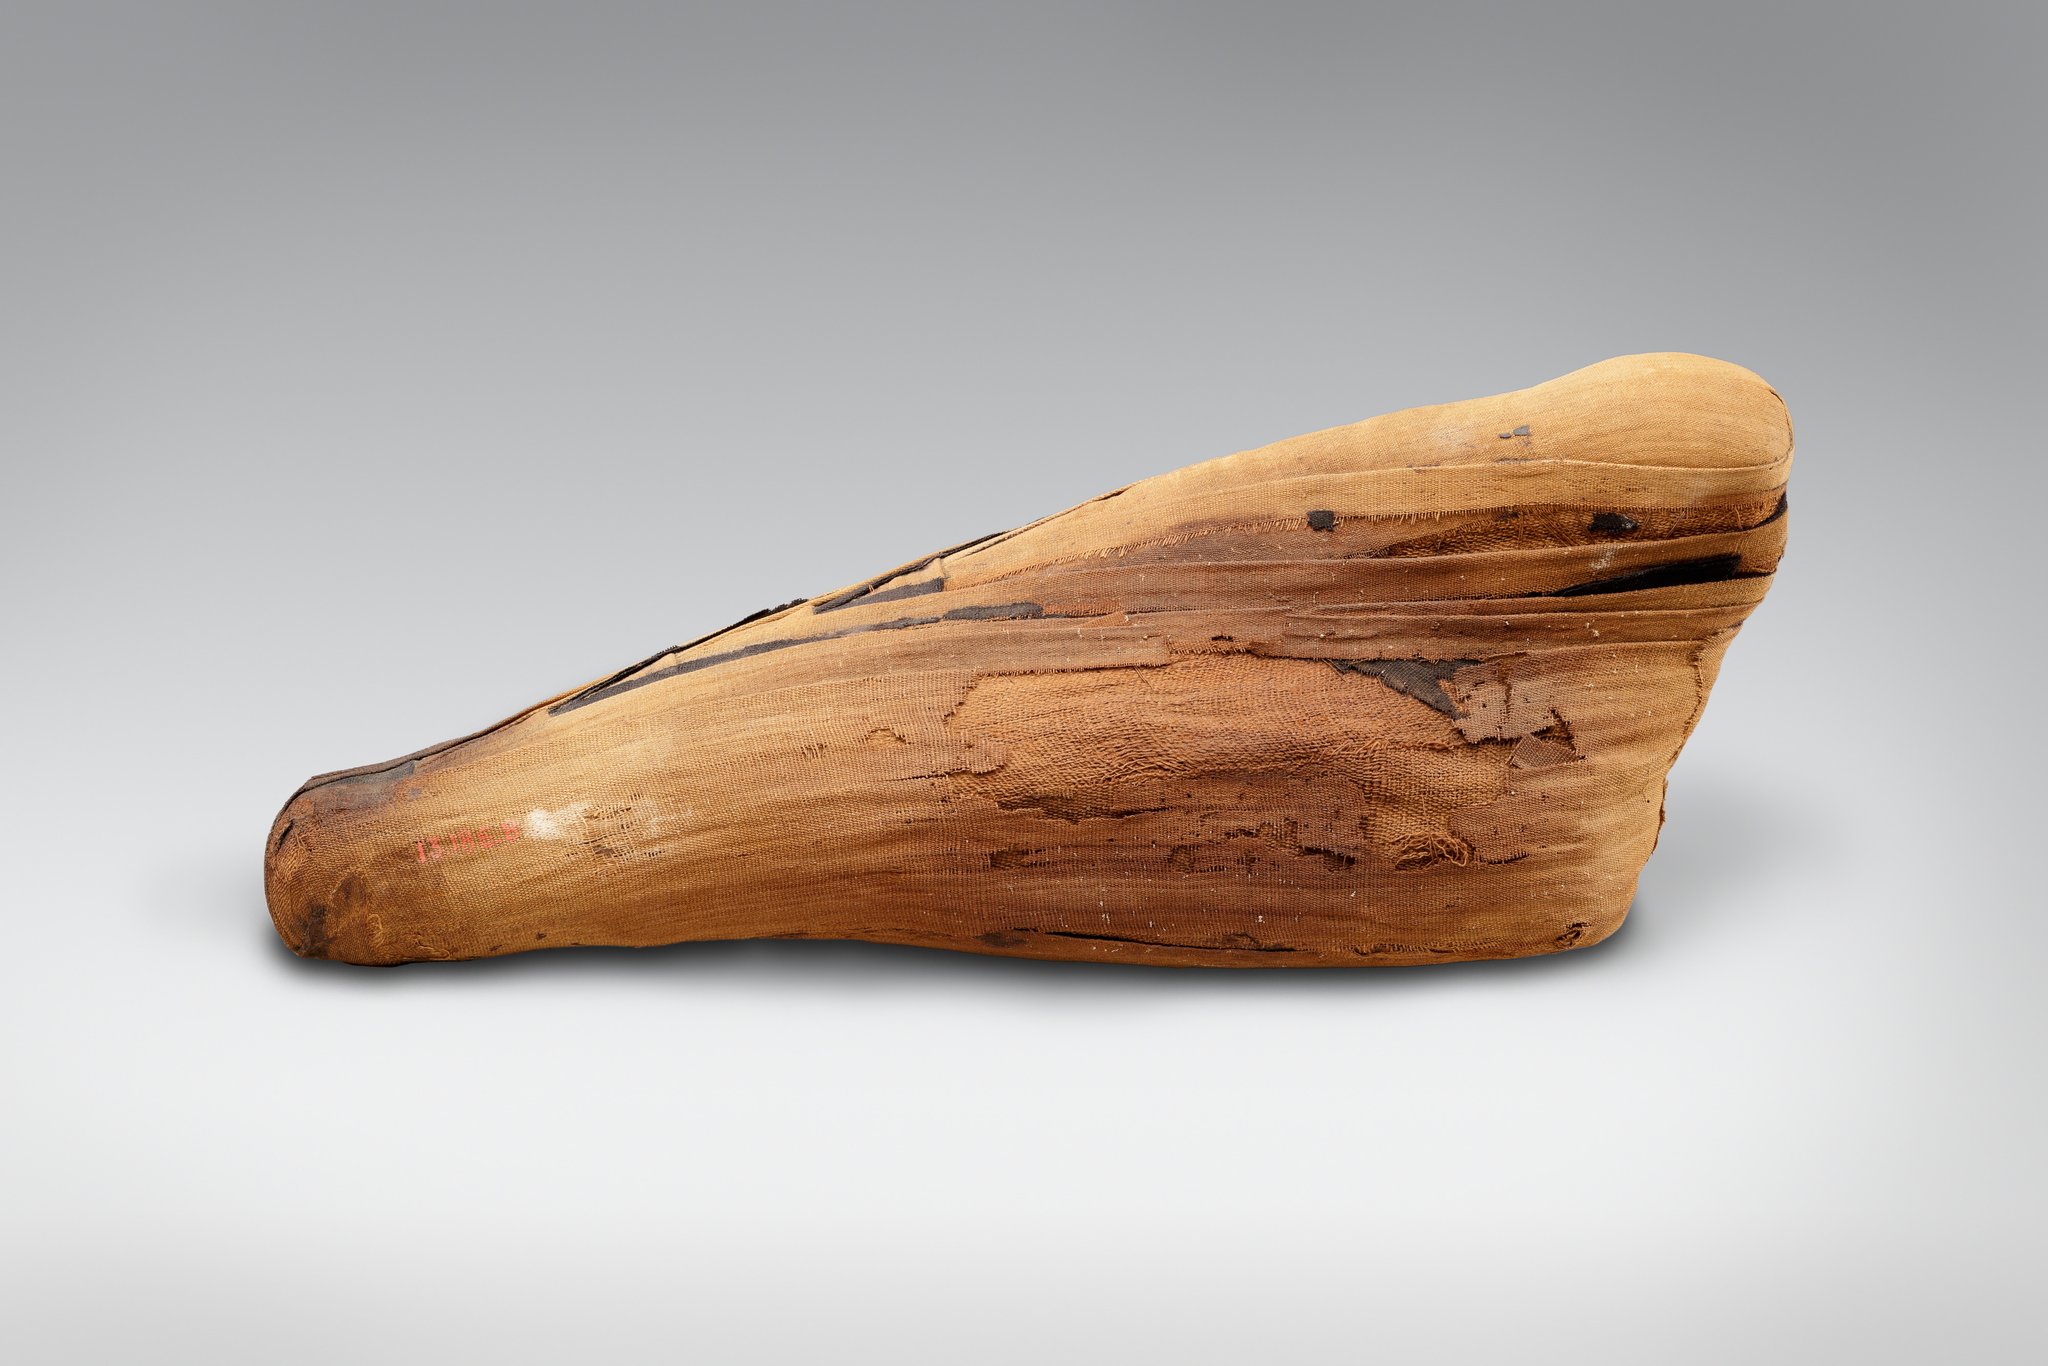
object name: mummy, ibis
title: Sacred animal mummy of an ibis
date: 400 BCE-100 CE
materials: linen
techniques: dyeing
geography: egypt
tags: animals,mummies